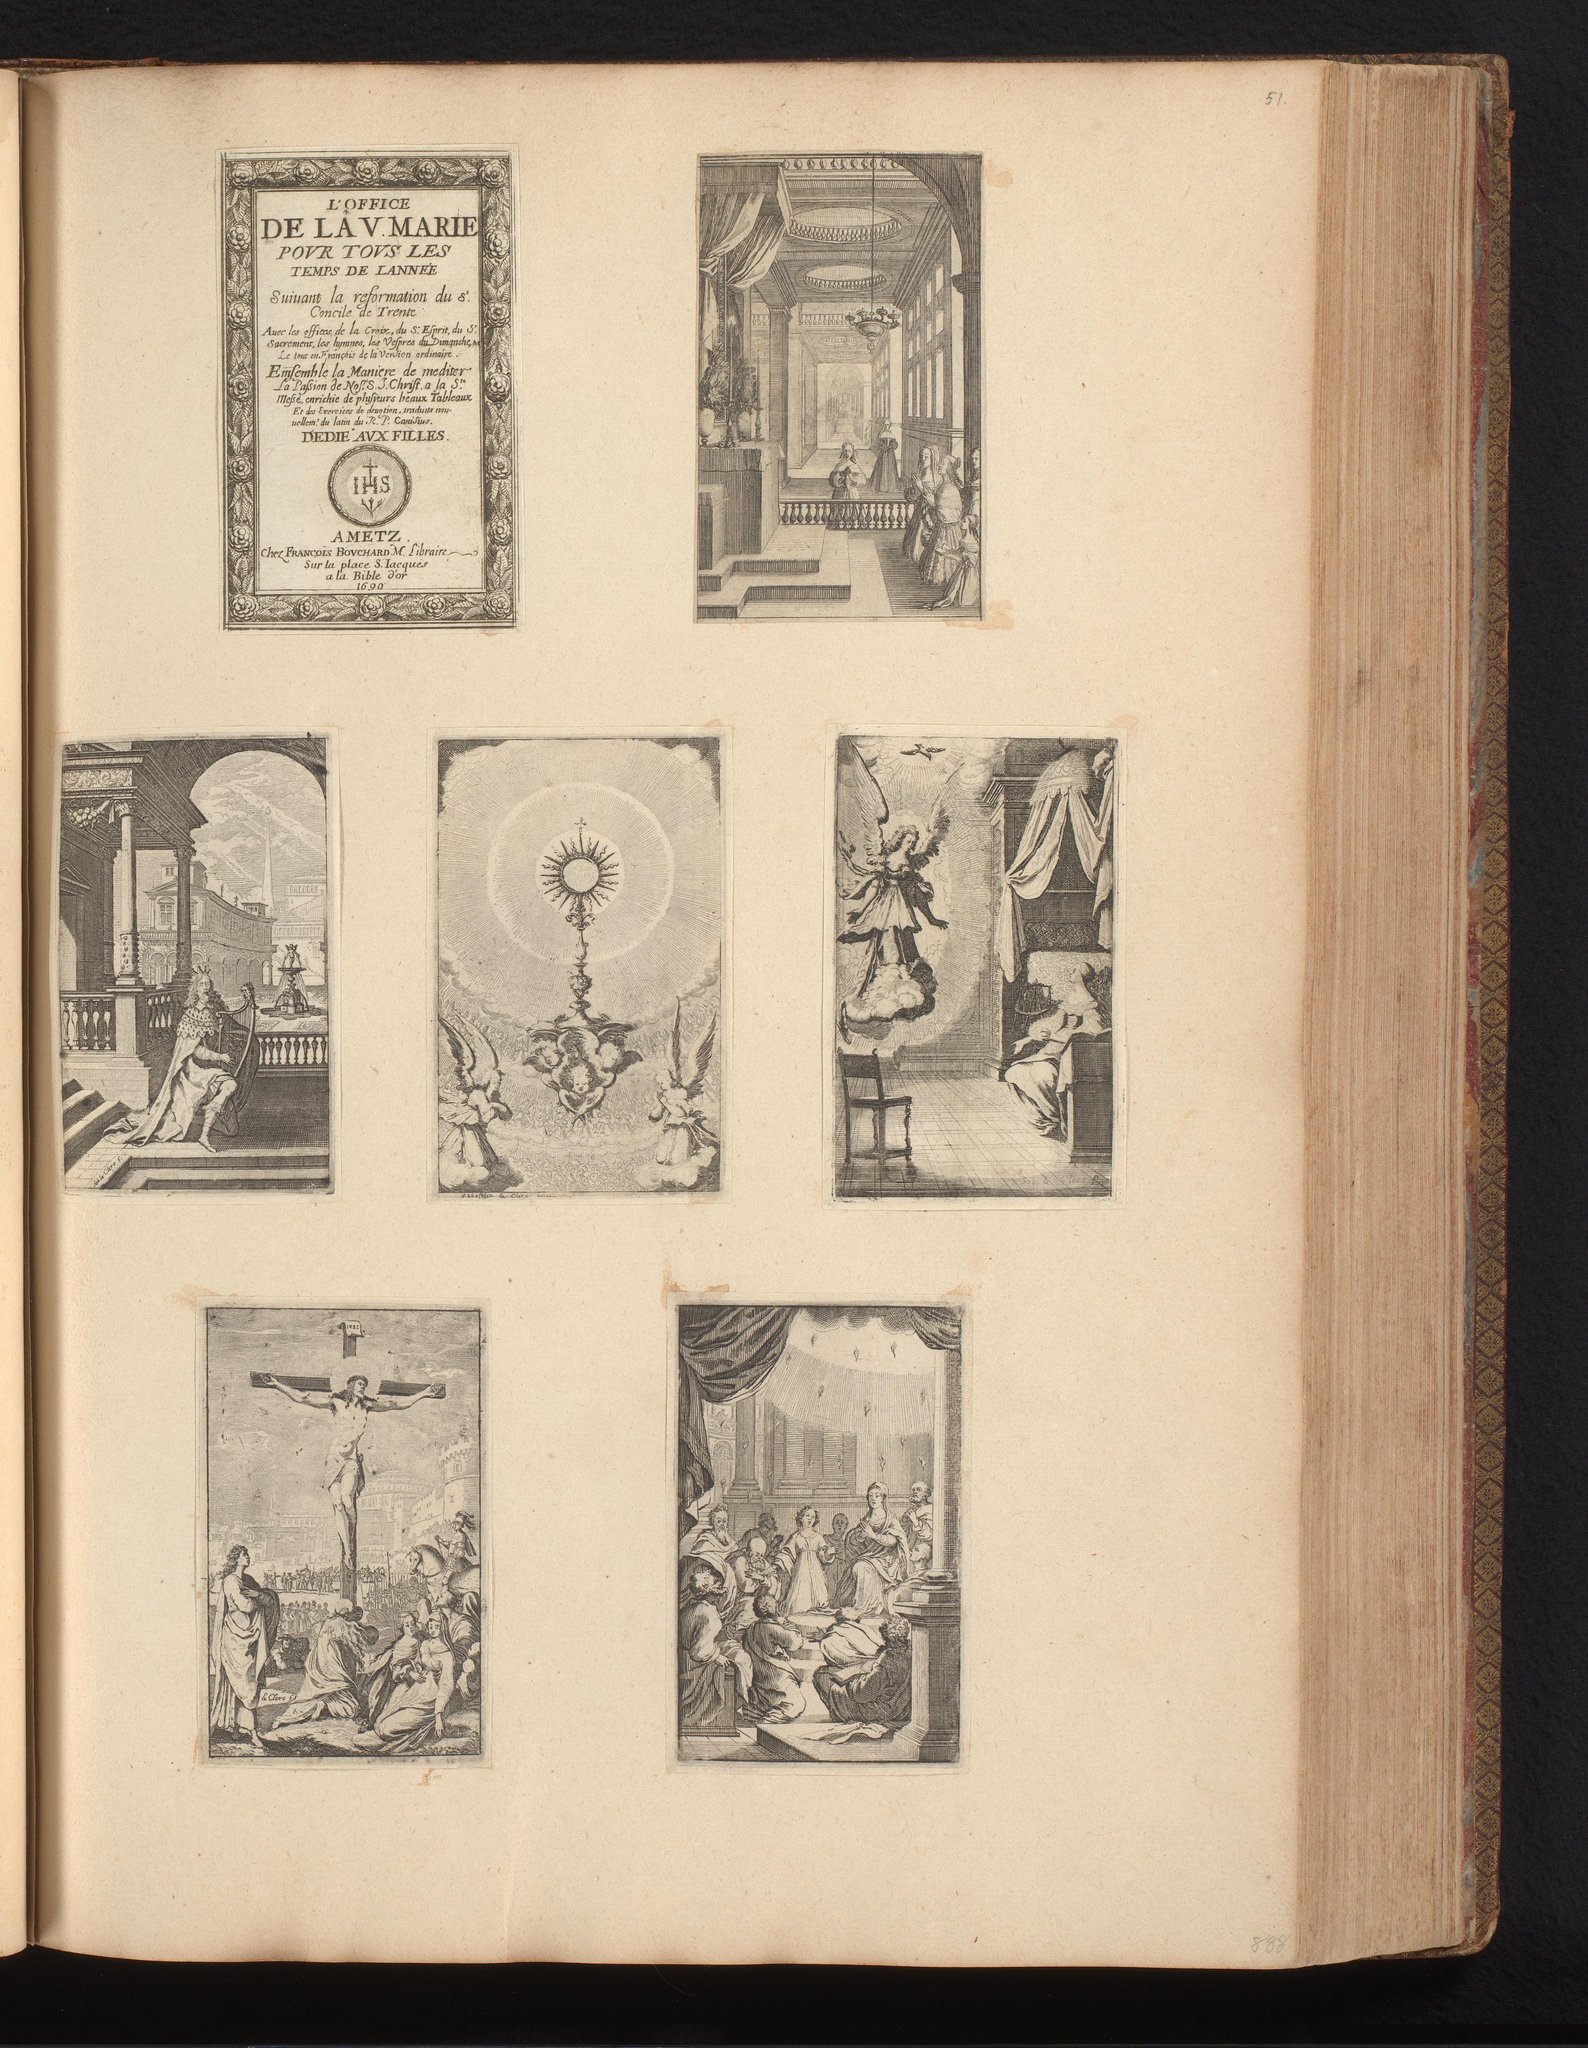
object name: print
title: L'Office de la V. Marie Pour Tous les Temps de Lanneé (...)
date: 1690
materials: paper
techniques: etching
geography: metz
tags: the annunciation: mary sitting, the crucifixion of christ: christ's death on the cross; golgotha (matthew 27:45-58; mark 15:33-45; luke 23:44-52; john 19:25-38), pentecost: the holy ghost descends upon (mary and) the apostles, sometimes paul and/or representatives of the nations present (acts 2:1-4)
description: Prenten gebruikt voor: Canisius, Pierre. L'Office de la V. Marie Pour Tous les Temps de Lanneé (...). Metz: François Bouchard, 1690.